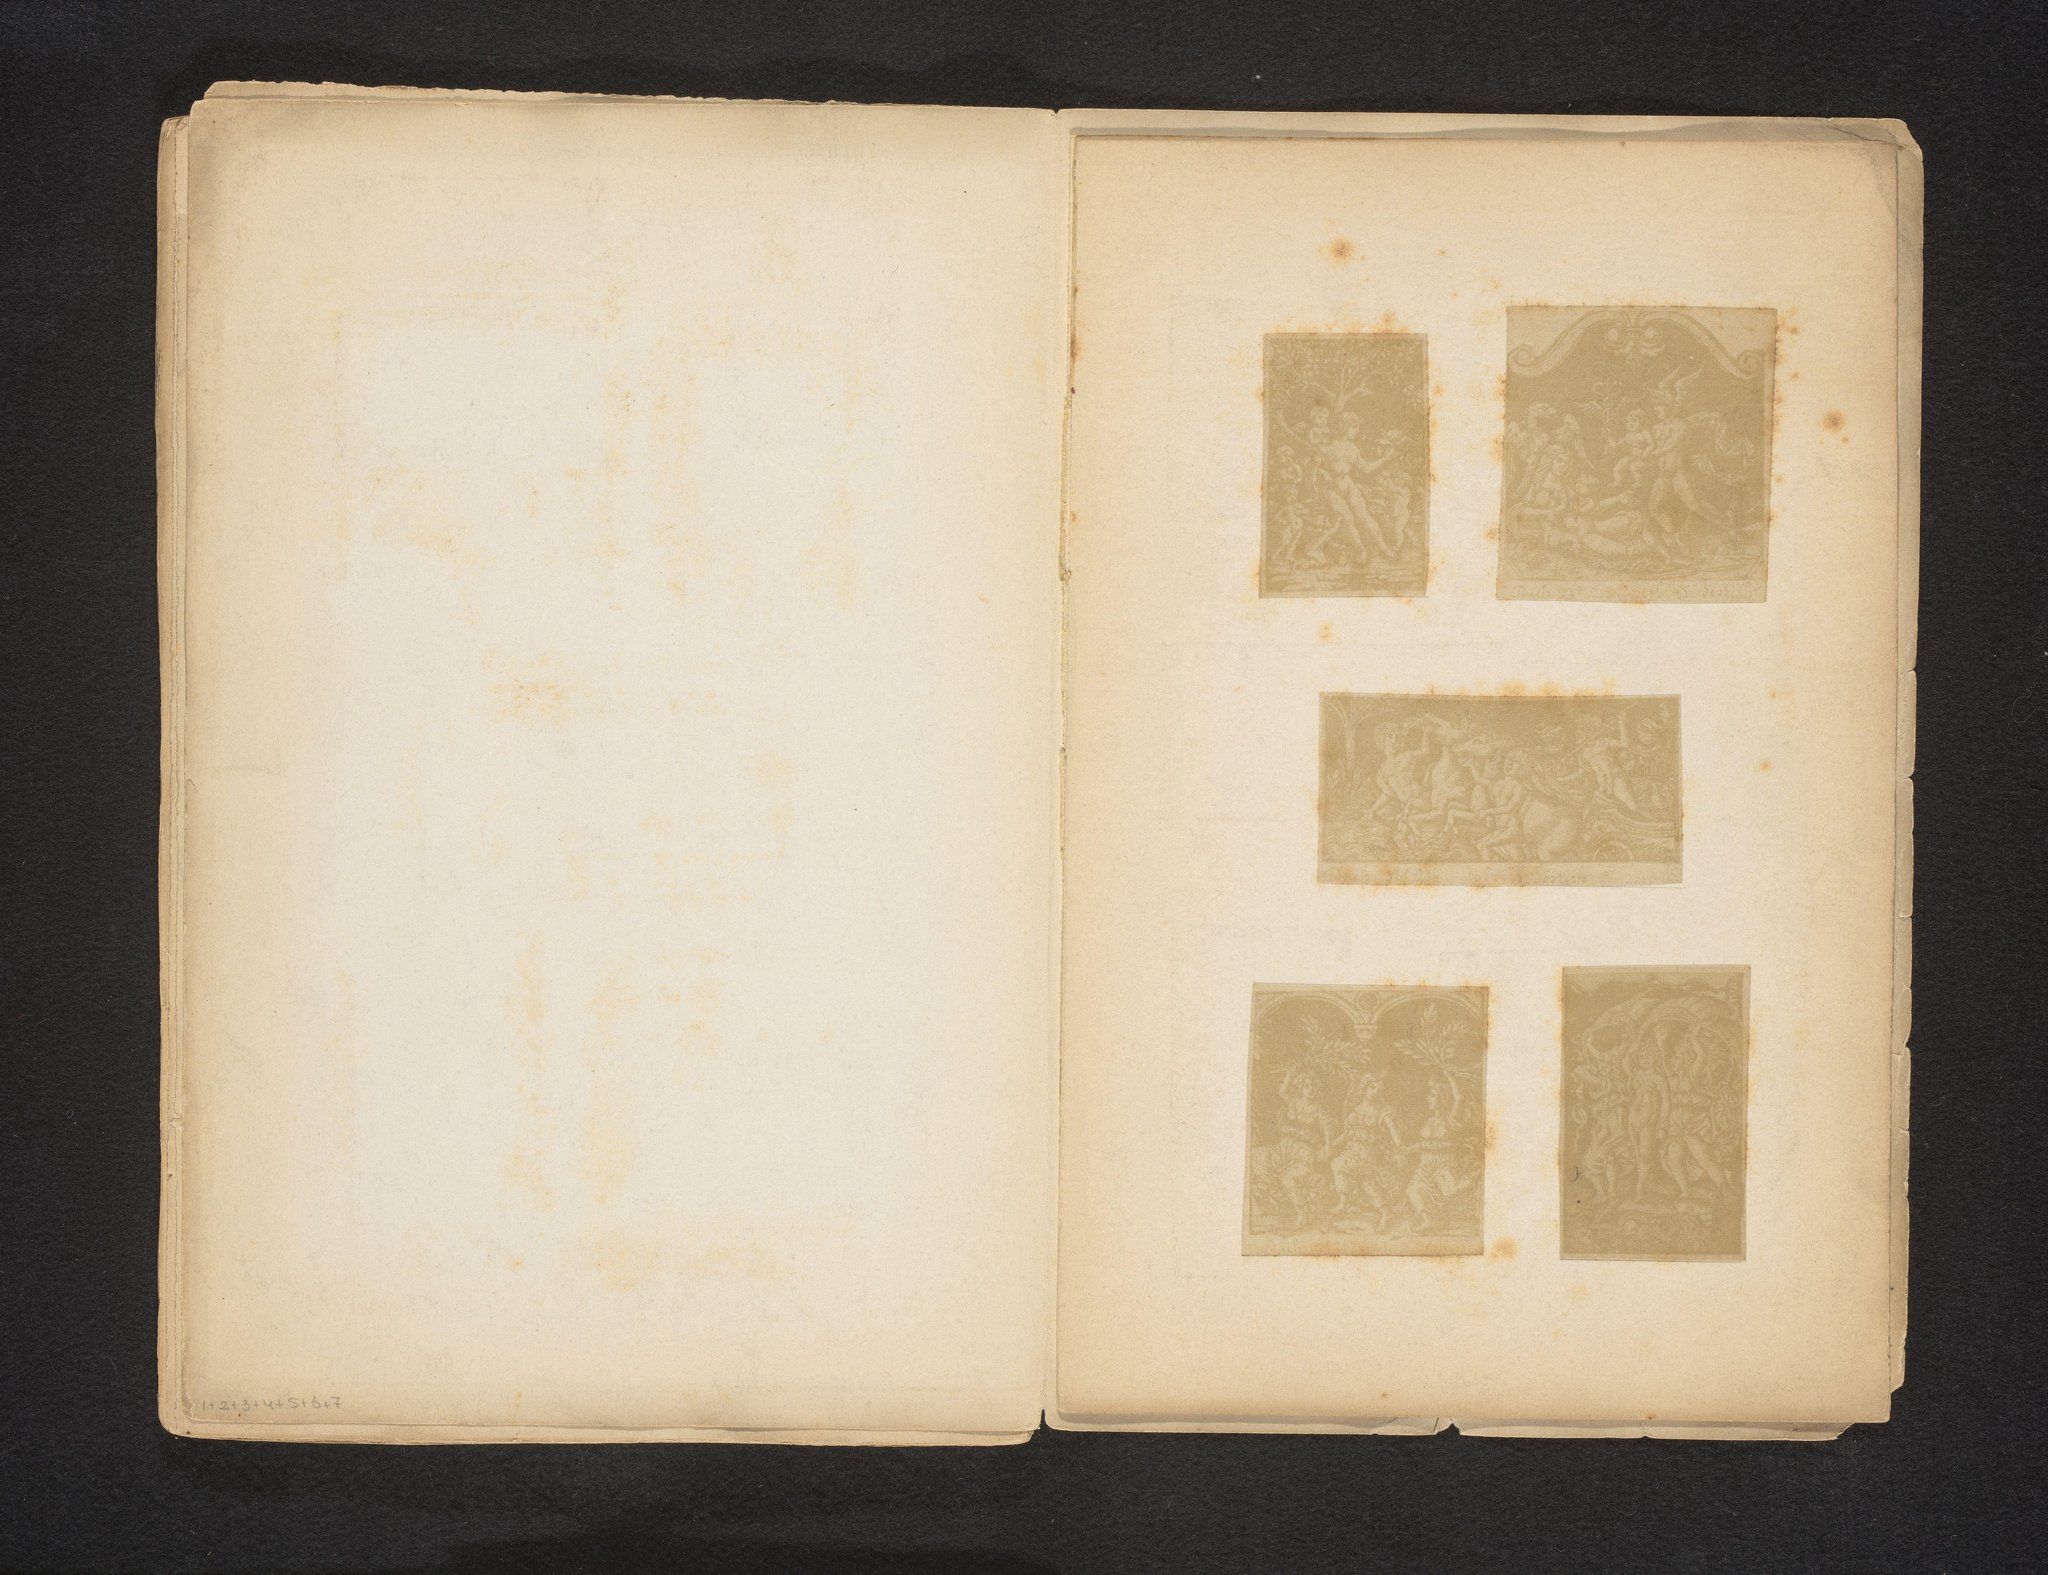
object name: page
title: Fotoreproductie van een prent van Mercurius die het kind Bacchus aan de nimfen van Nysa geeft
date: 1852-1857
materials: photographic support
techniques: salted paper print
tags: mercury hands the baby bacchus over to the nymphs of nysa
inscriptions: inscription: ‘Duch. No. 218. col. V. Sestich’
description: Foto op blad met vijf foto's op derde ongenummerde pagina na pagina 60.